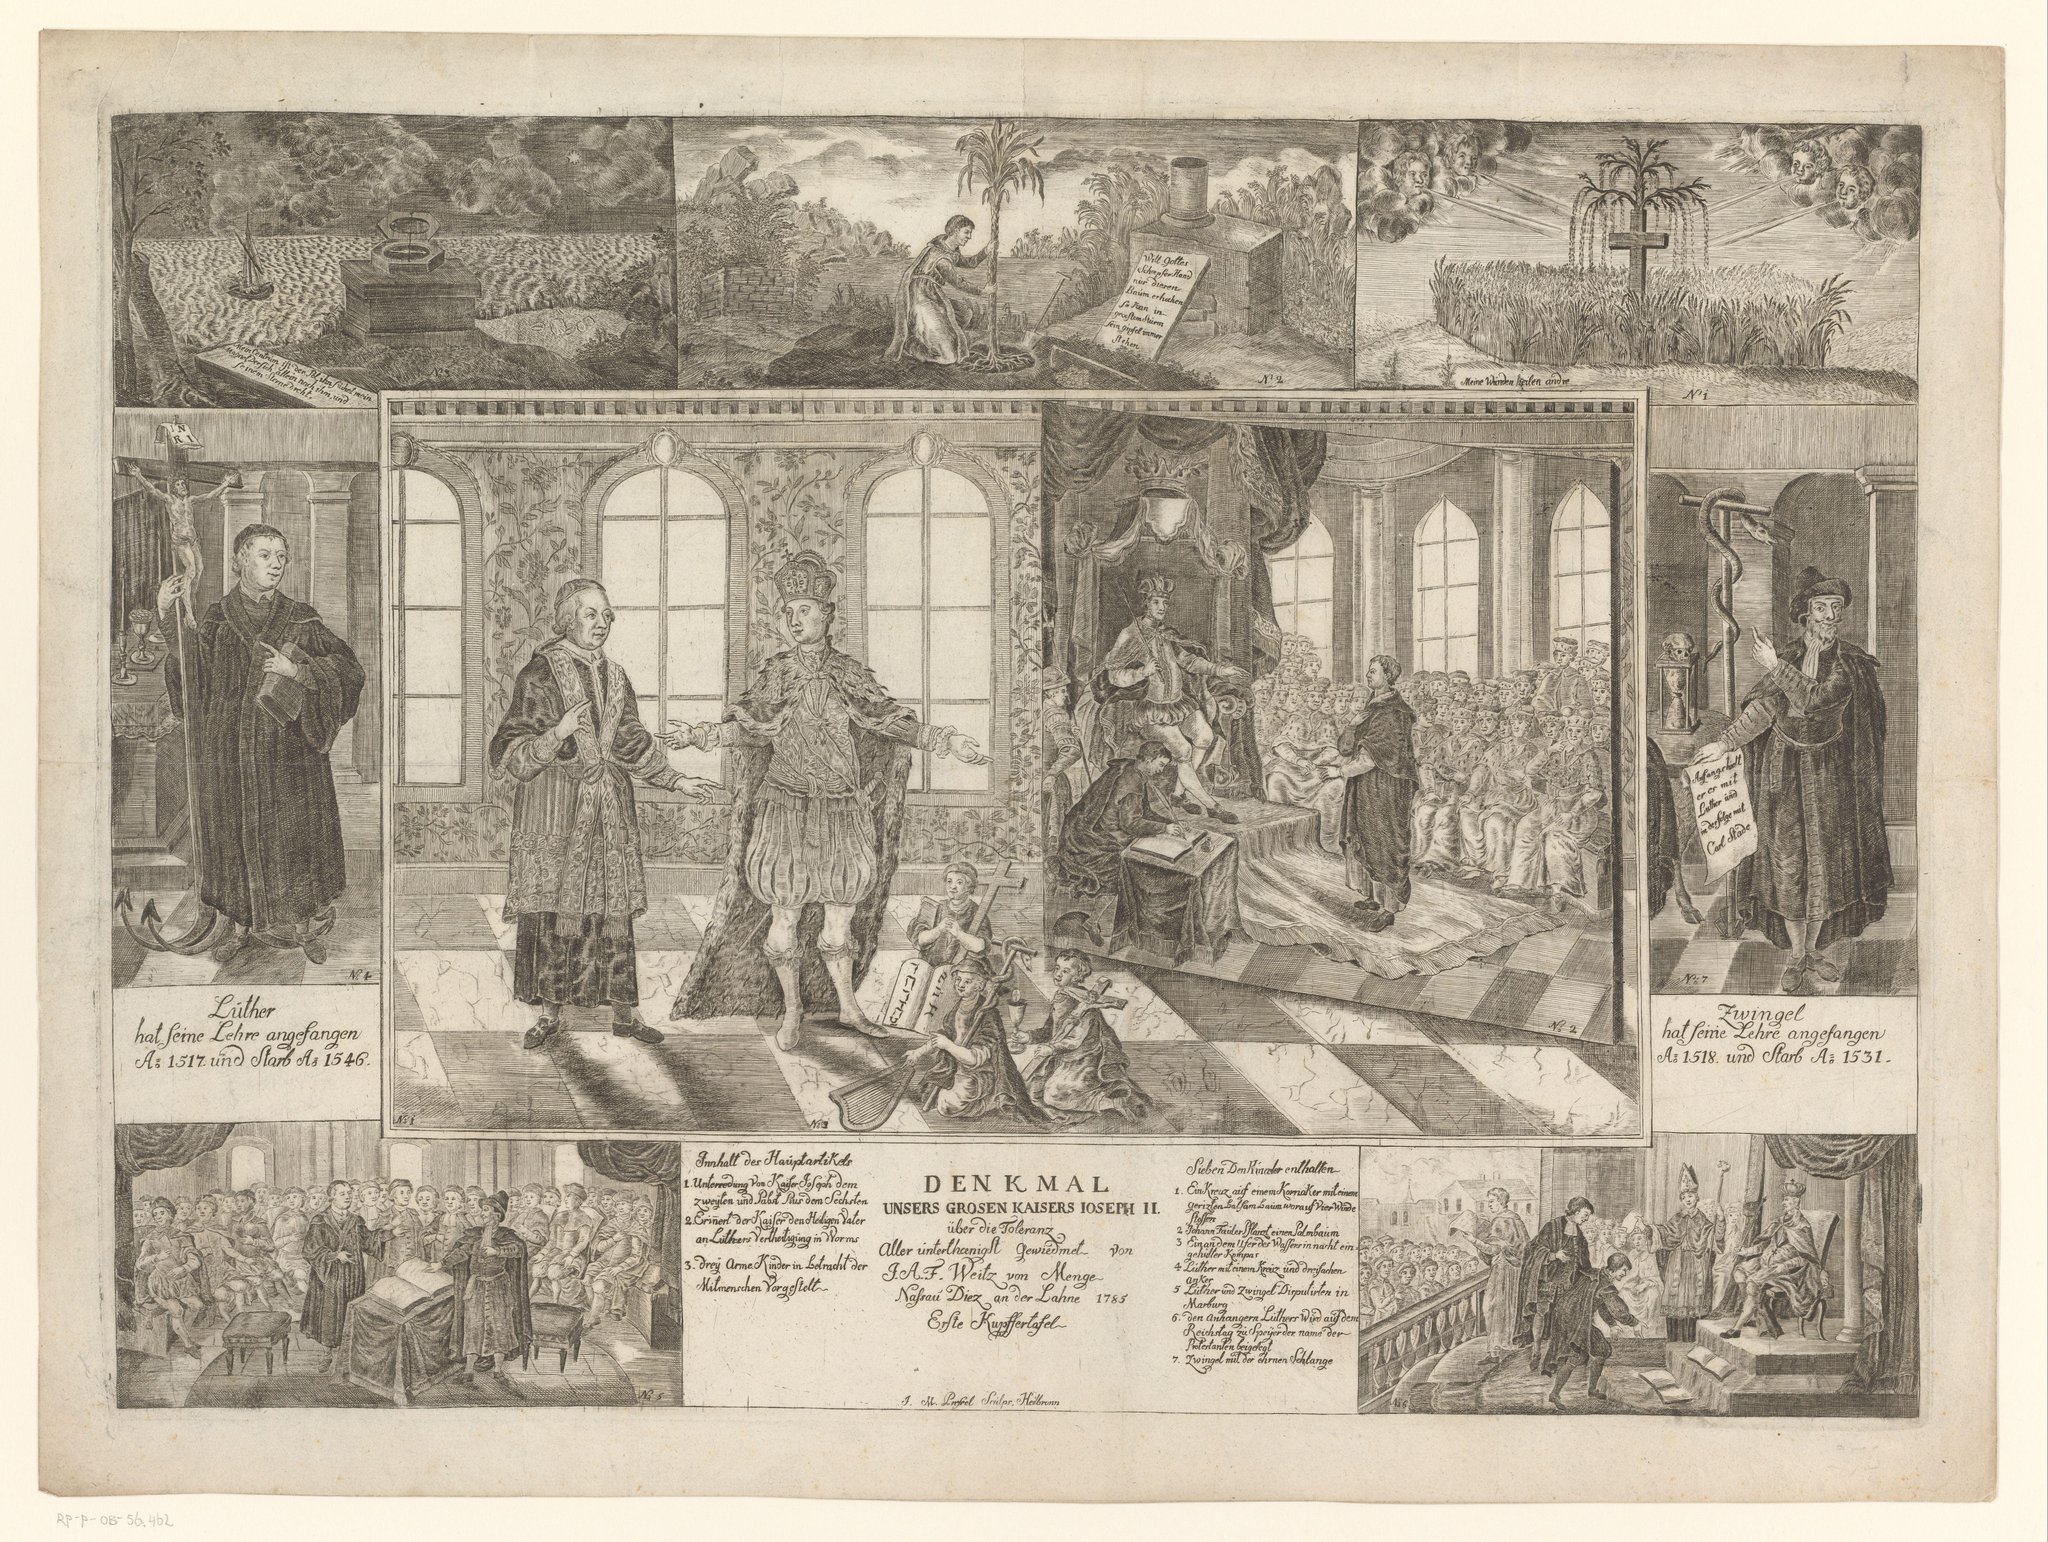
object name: print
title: Zeven voorstellingen over het leven en de daden van keizer Joseph II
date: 1785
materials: paper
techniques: etching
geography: heilbronn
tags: vienna, jozef ii (duits keizer), historical persons, pope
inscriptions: collector's mark: Lugt 2228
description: Deze prent maakt mogelijk deel uit van: 'Toleranzgeschichte: in vier erklärten Kupfertafeln' uit 1785.